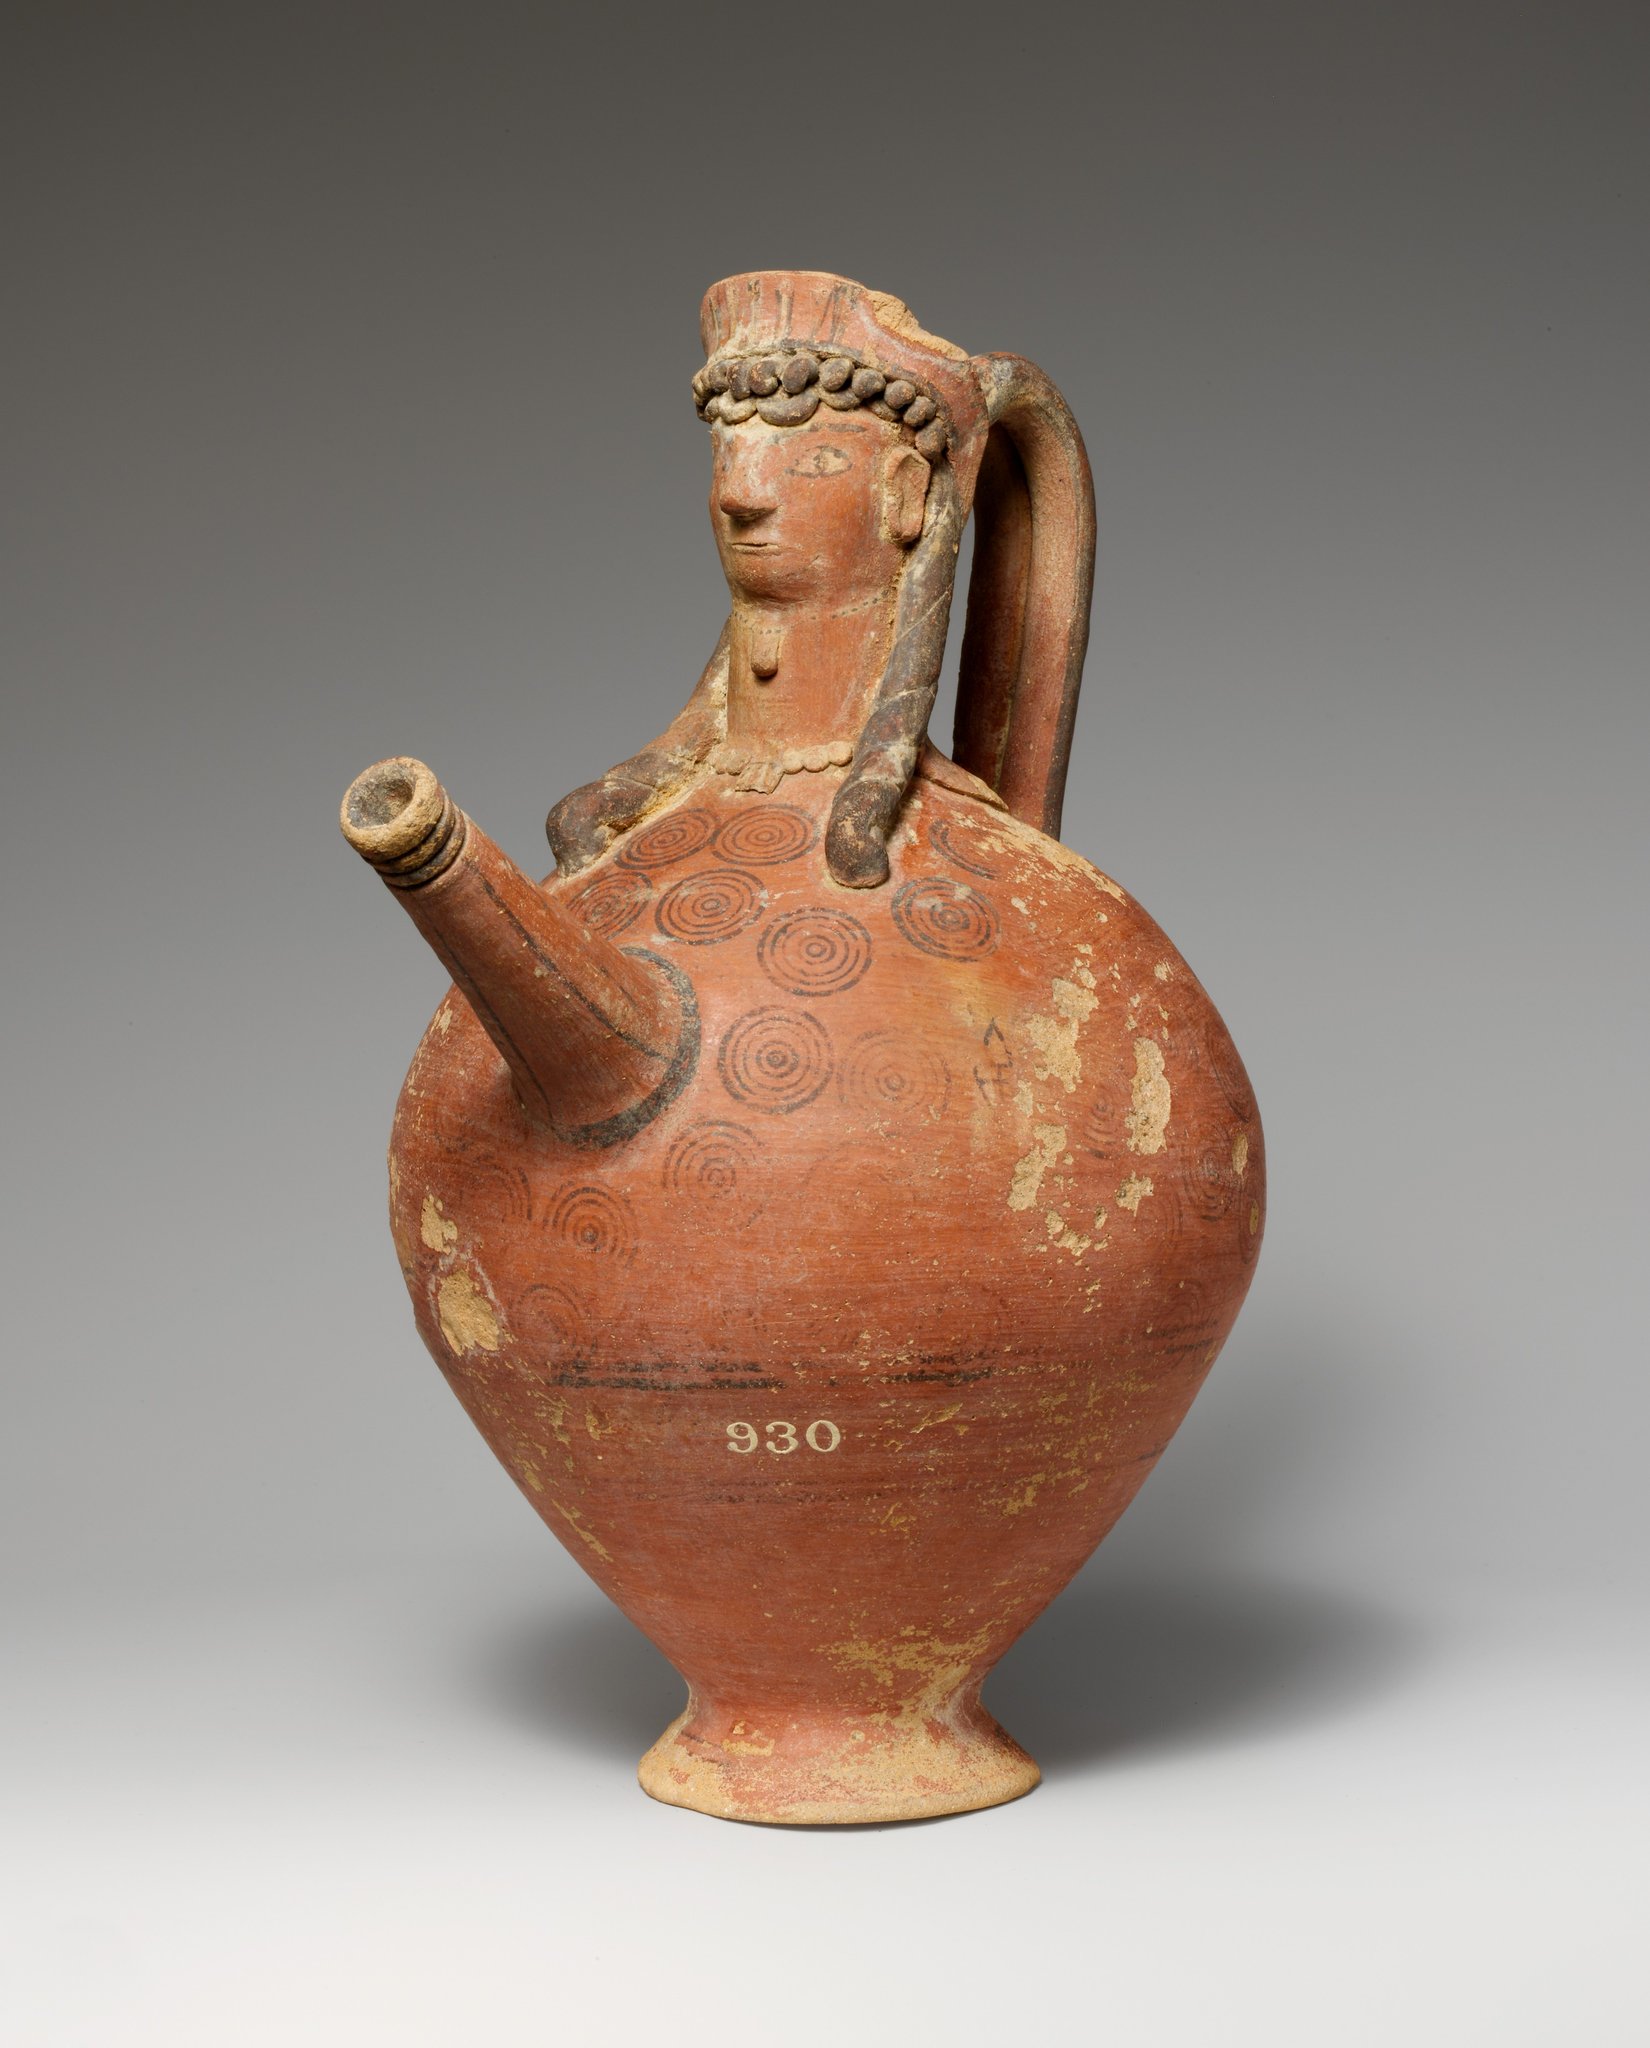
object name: jug with female head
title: Terracotta trick vase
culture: cypriot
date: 750-600 BCE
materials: terracotta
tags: heads,women